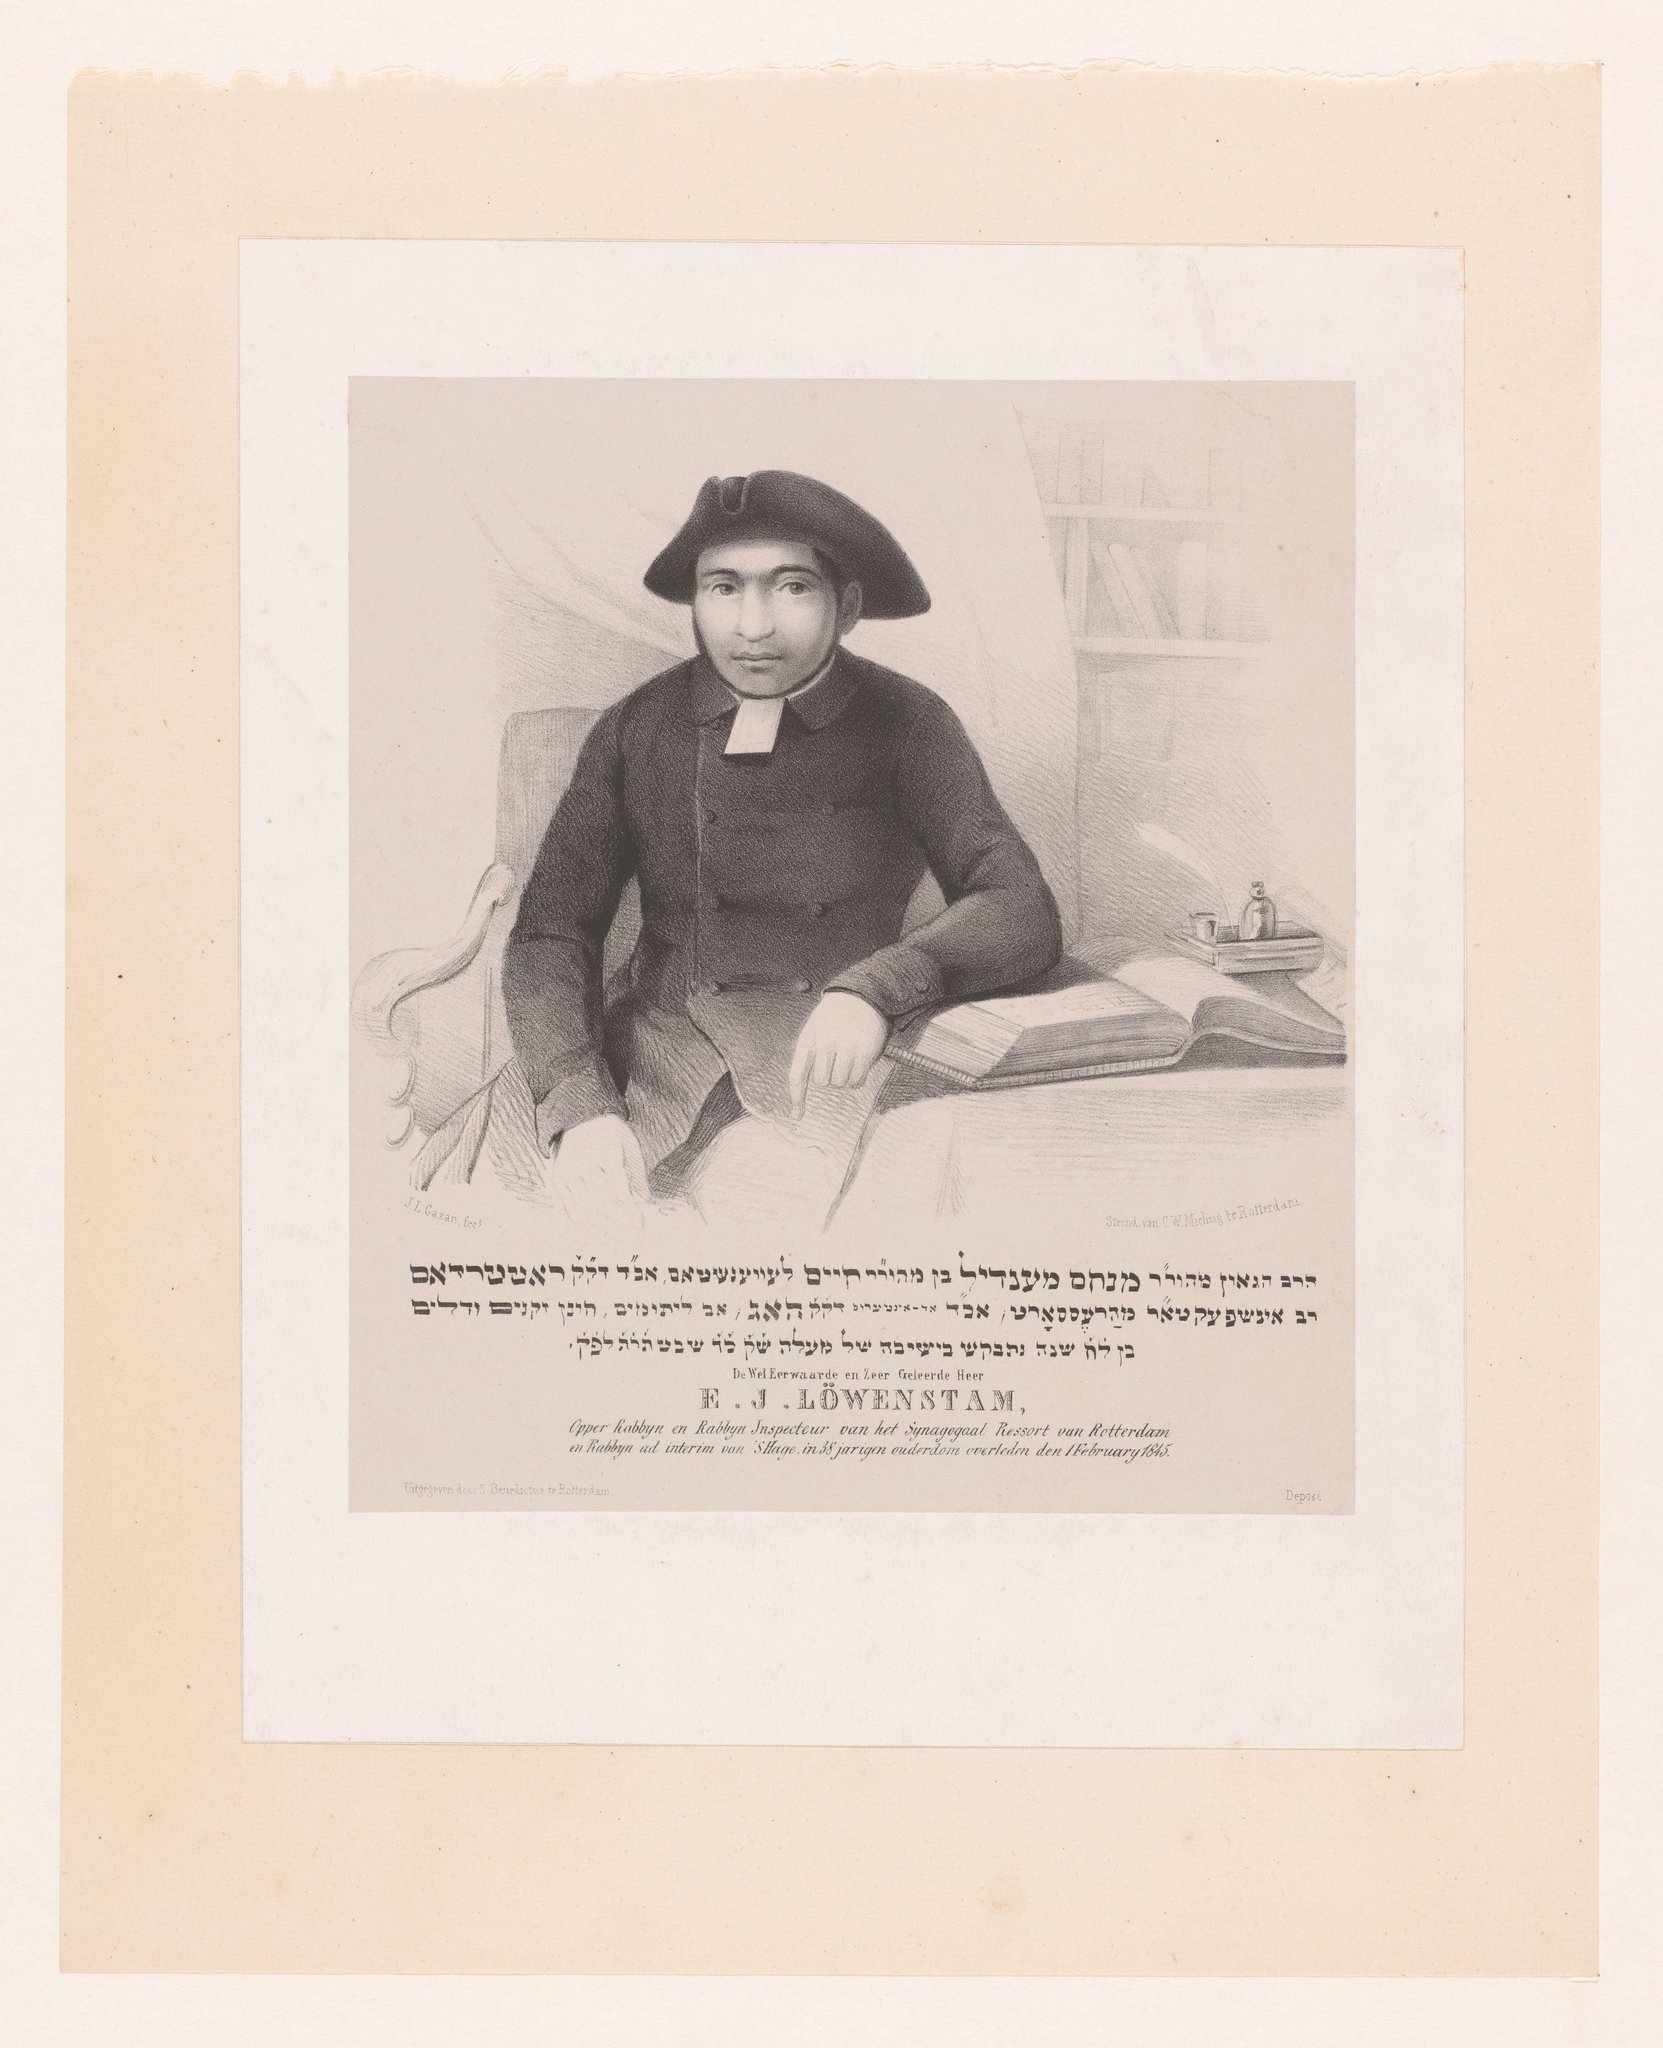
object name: print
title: Portret van opperrabijn Emanuel Joachim Löwenstam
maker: izak levi gazan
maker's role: print maker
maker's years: 1824-1881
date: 1844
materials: paper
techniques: lithograph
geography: rotterdam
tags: book - mm - book open, chief rabbi, historical persons (+ (full) bust portrait)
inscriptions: : ‘Deposé’, collector's mark: Lugt 2228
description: De geportretteerde zit aan een tafel en leunt met zijn linkerelleboog op een opengeslagen boek. Onder het portret een tekst in het Hebreeuws, zijn naam en beroep.